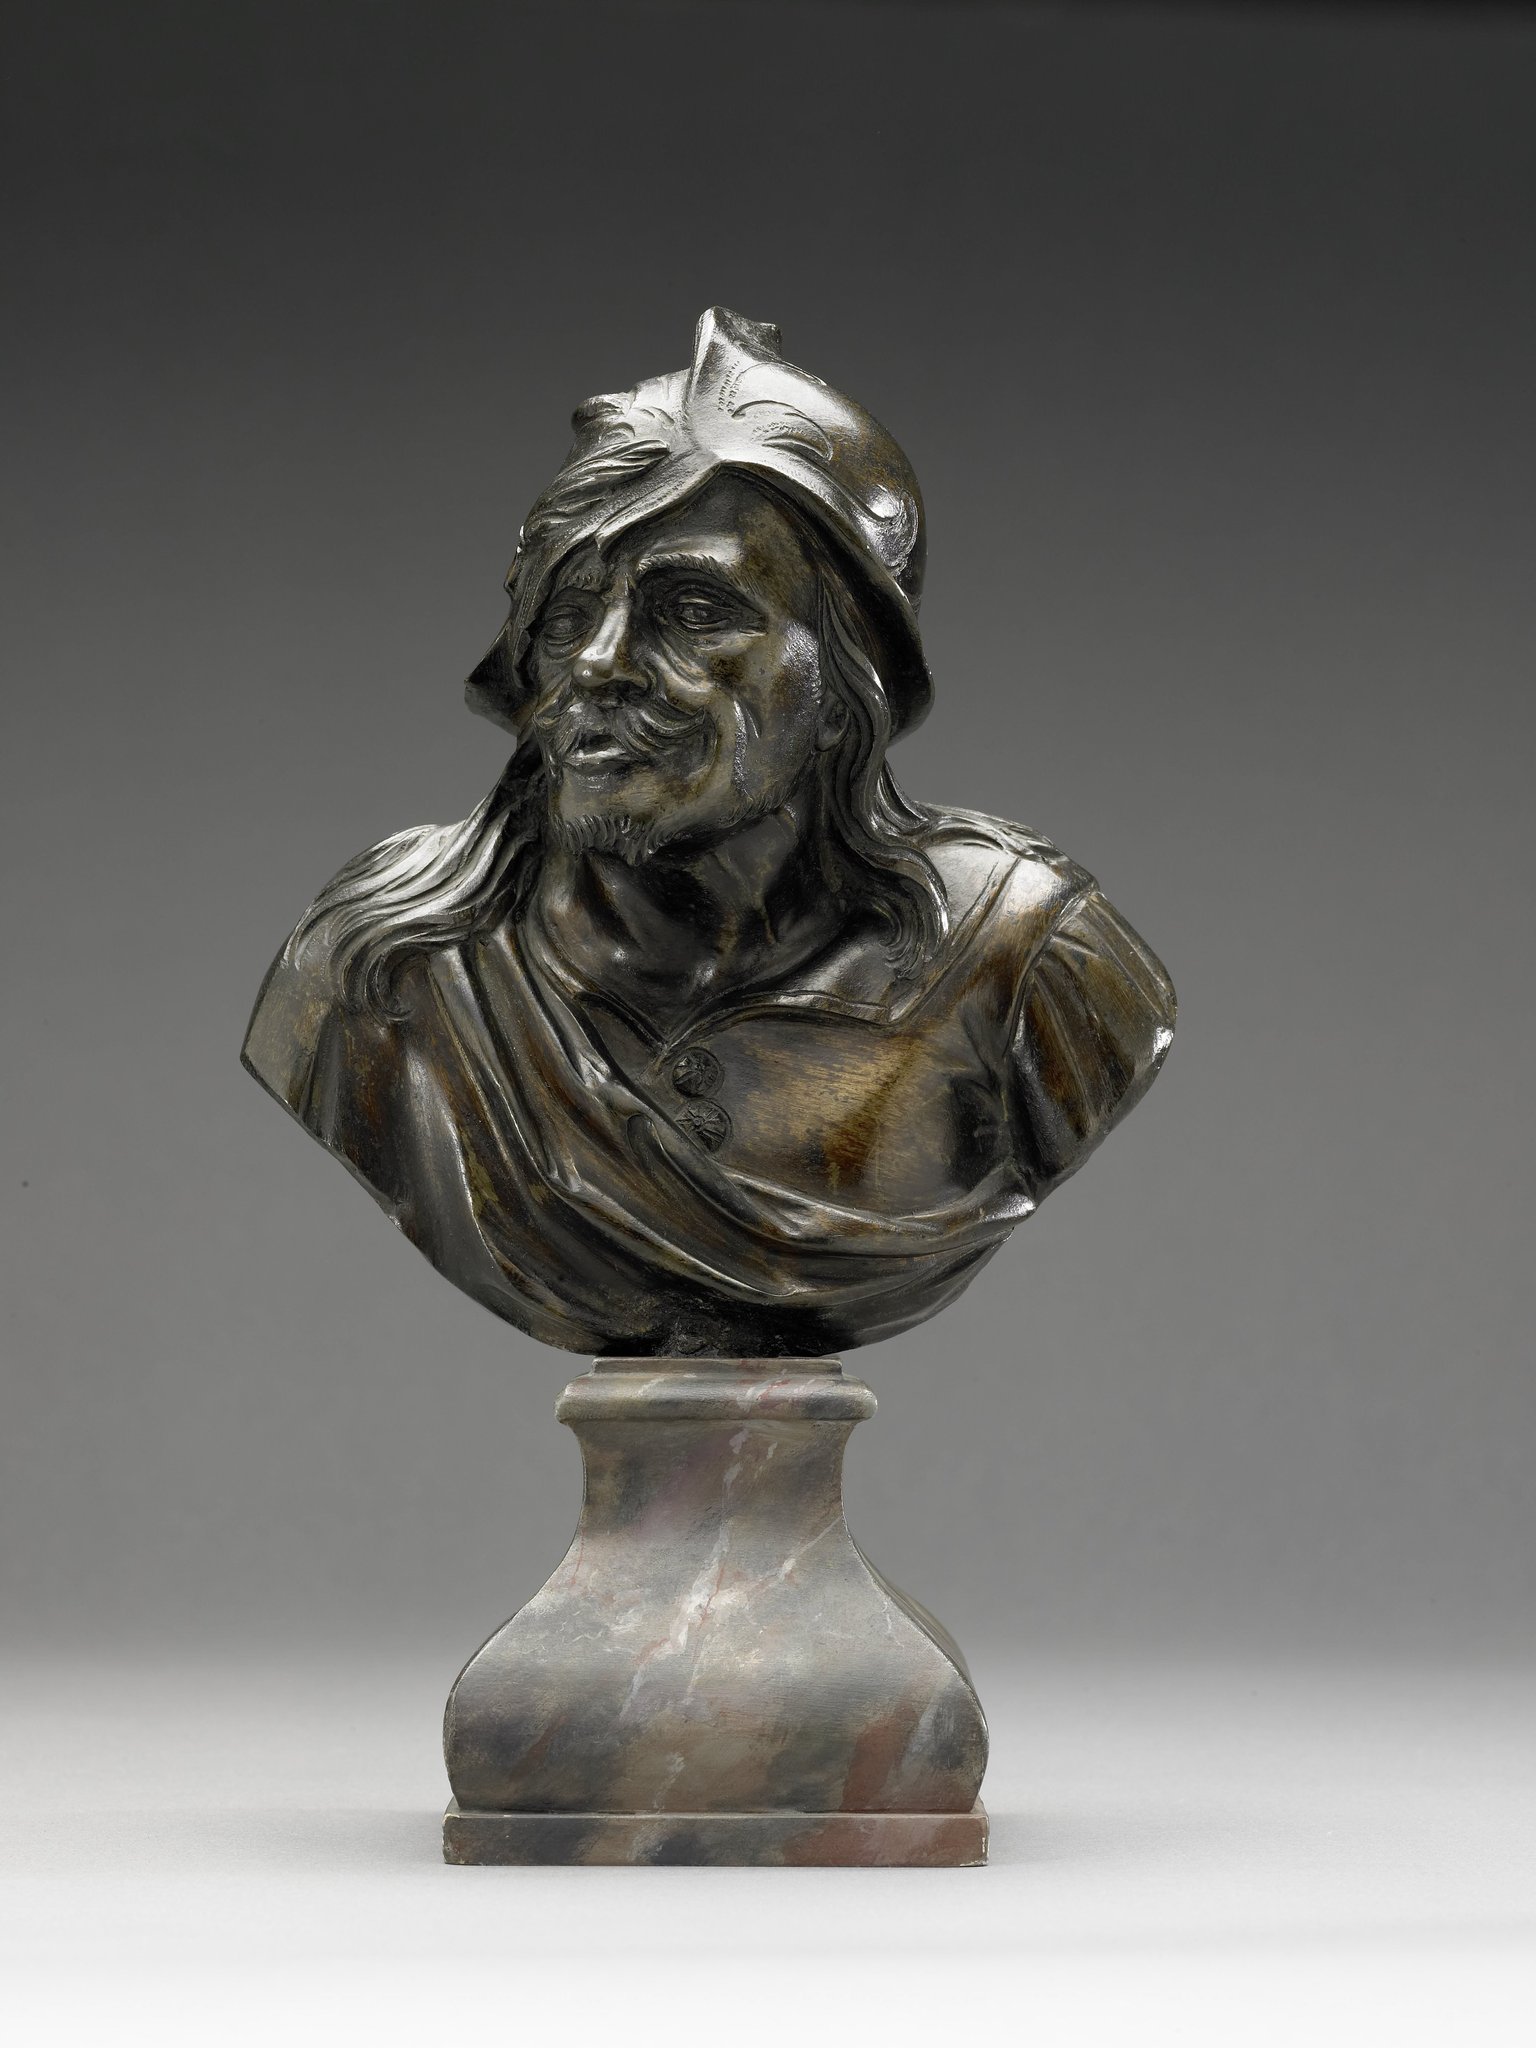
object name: sculpture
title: Jocular Character or Actor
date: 1675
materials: bronze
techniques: casting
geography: leiden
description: Pieter Xavery (c. 1647 - 1674), attributed. Two busts of a man. Bronze.